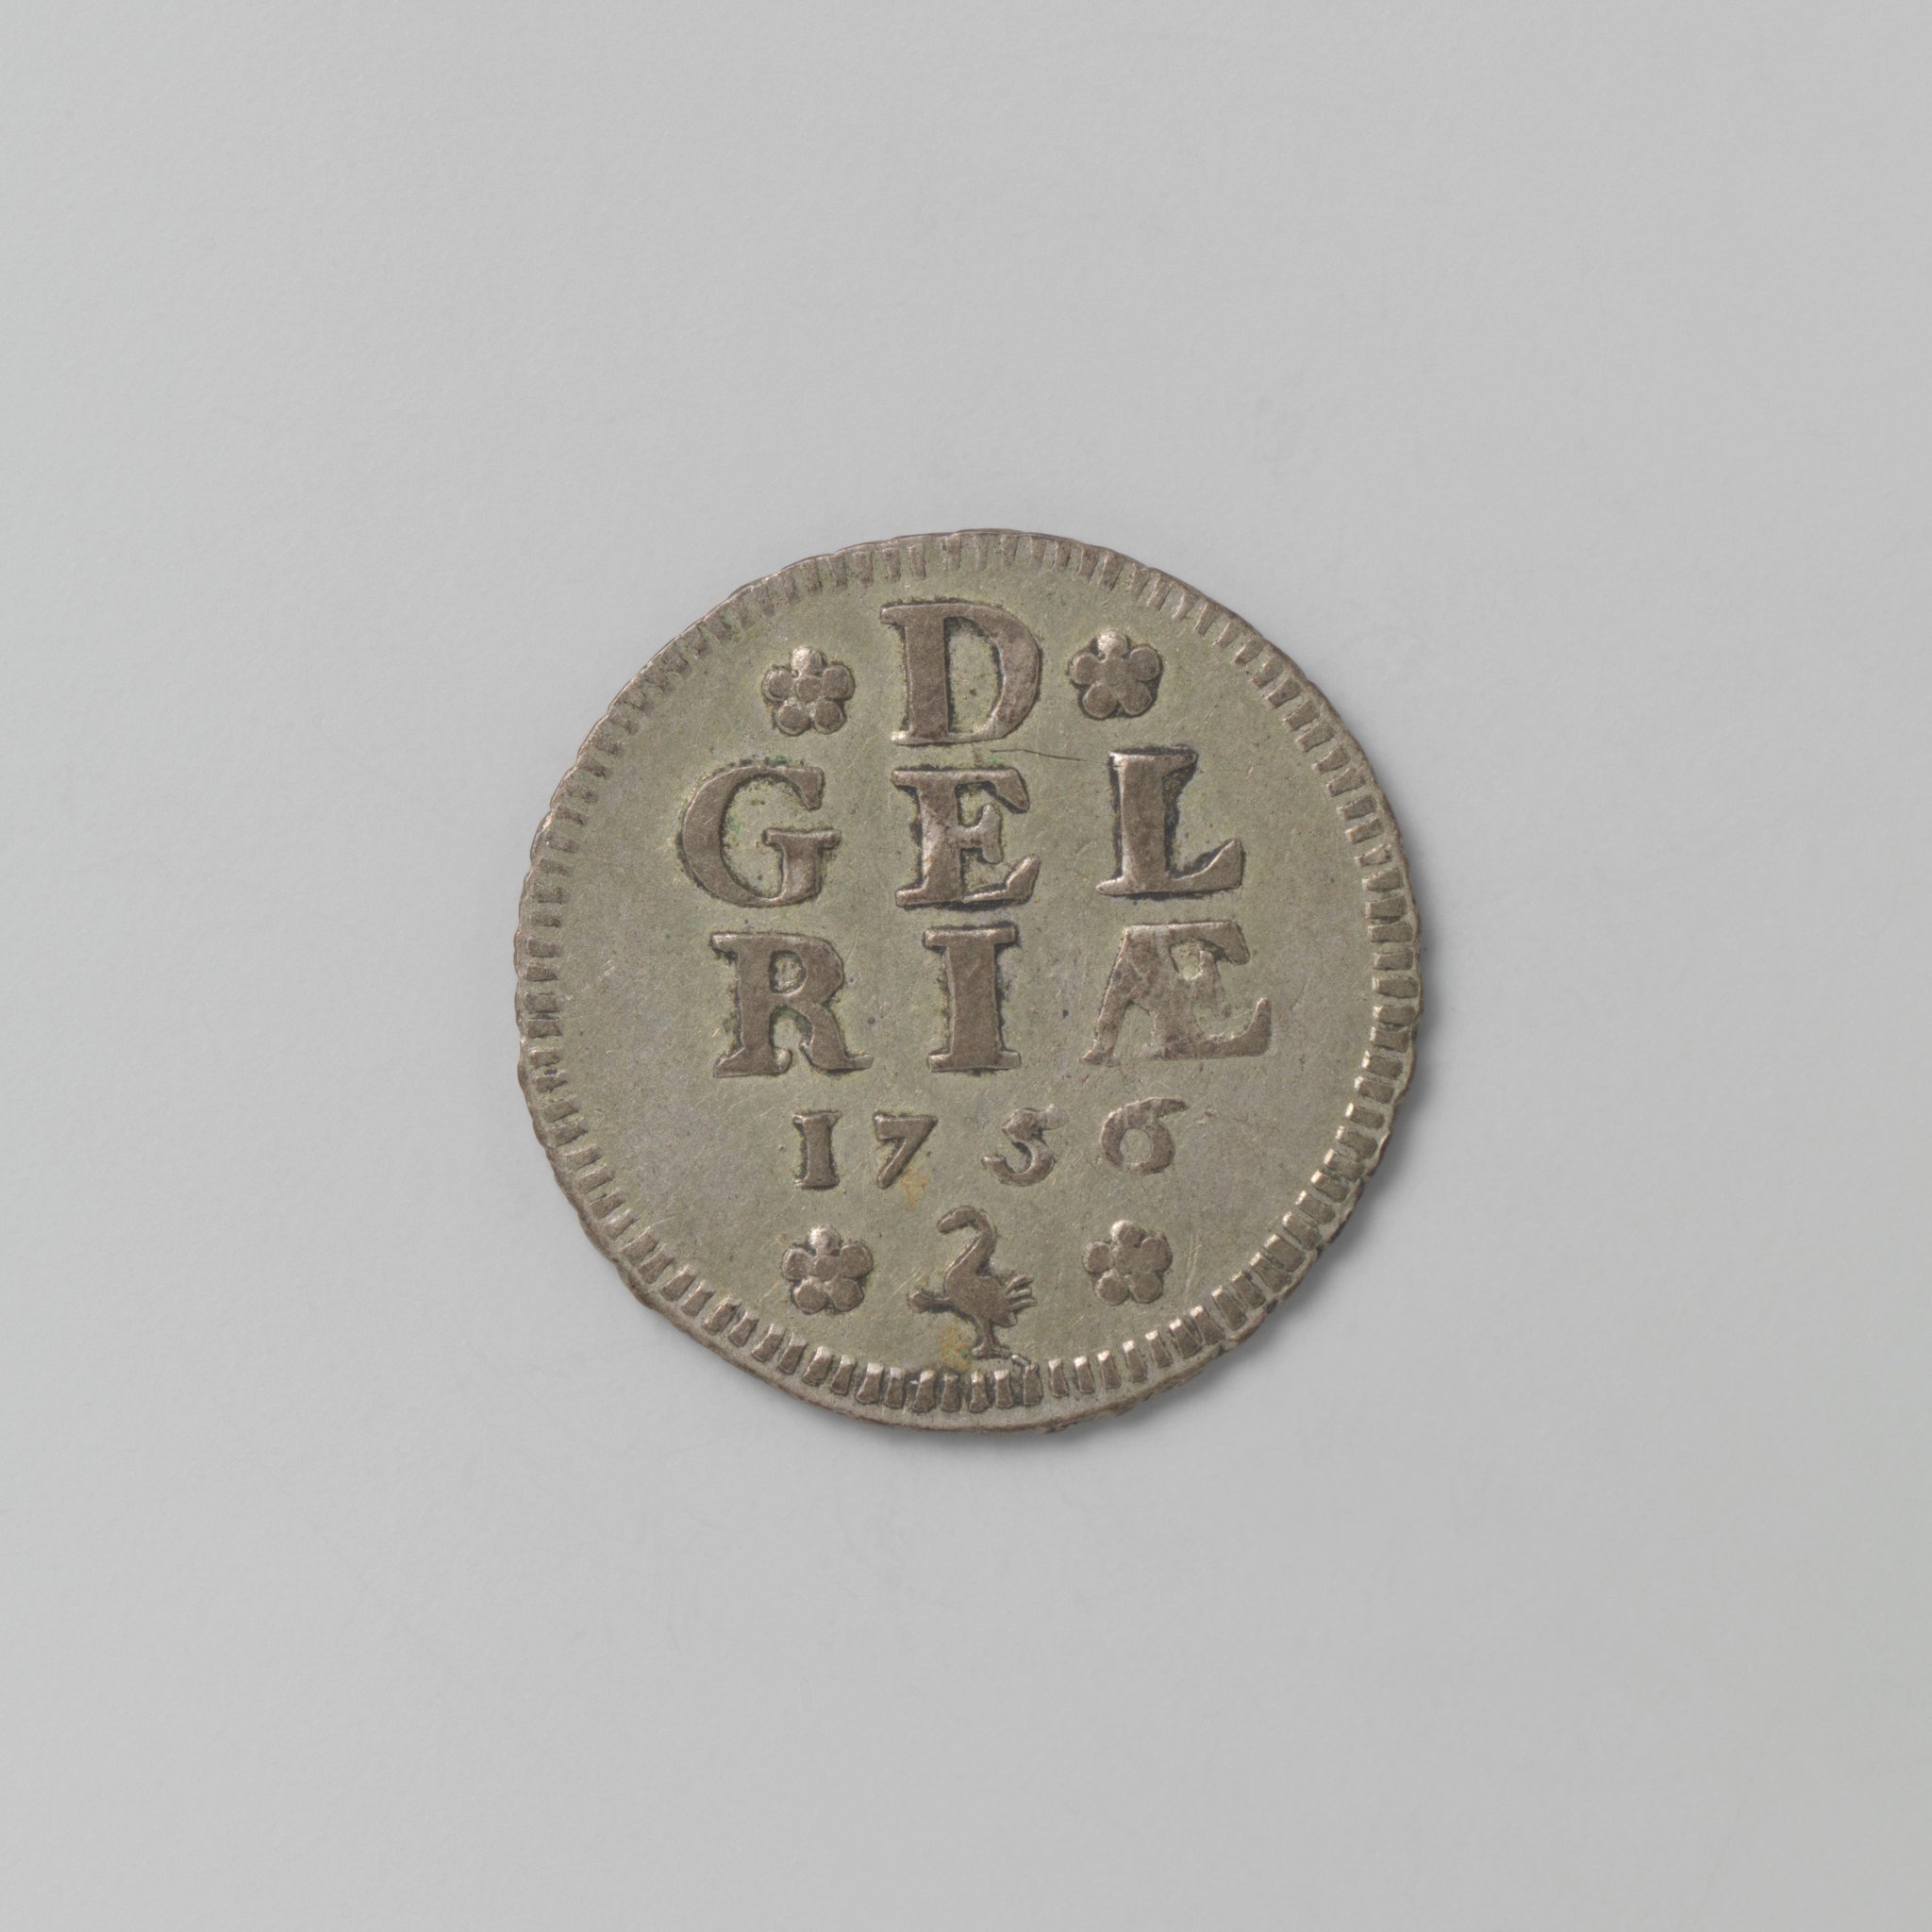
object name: coin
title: Gelderland, halve duit, 1756. Zilveren afslag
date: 1756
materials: silver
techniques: striking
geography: harderwijk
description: Zilveren munt. Voorzijde: in drie regels D/GEL/RIAE, daaronder jaartal en muntmeesterteken. Keerzijde: gekroond Gelders wapenschild. Afslag in zilver.